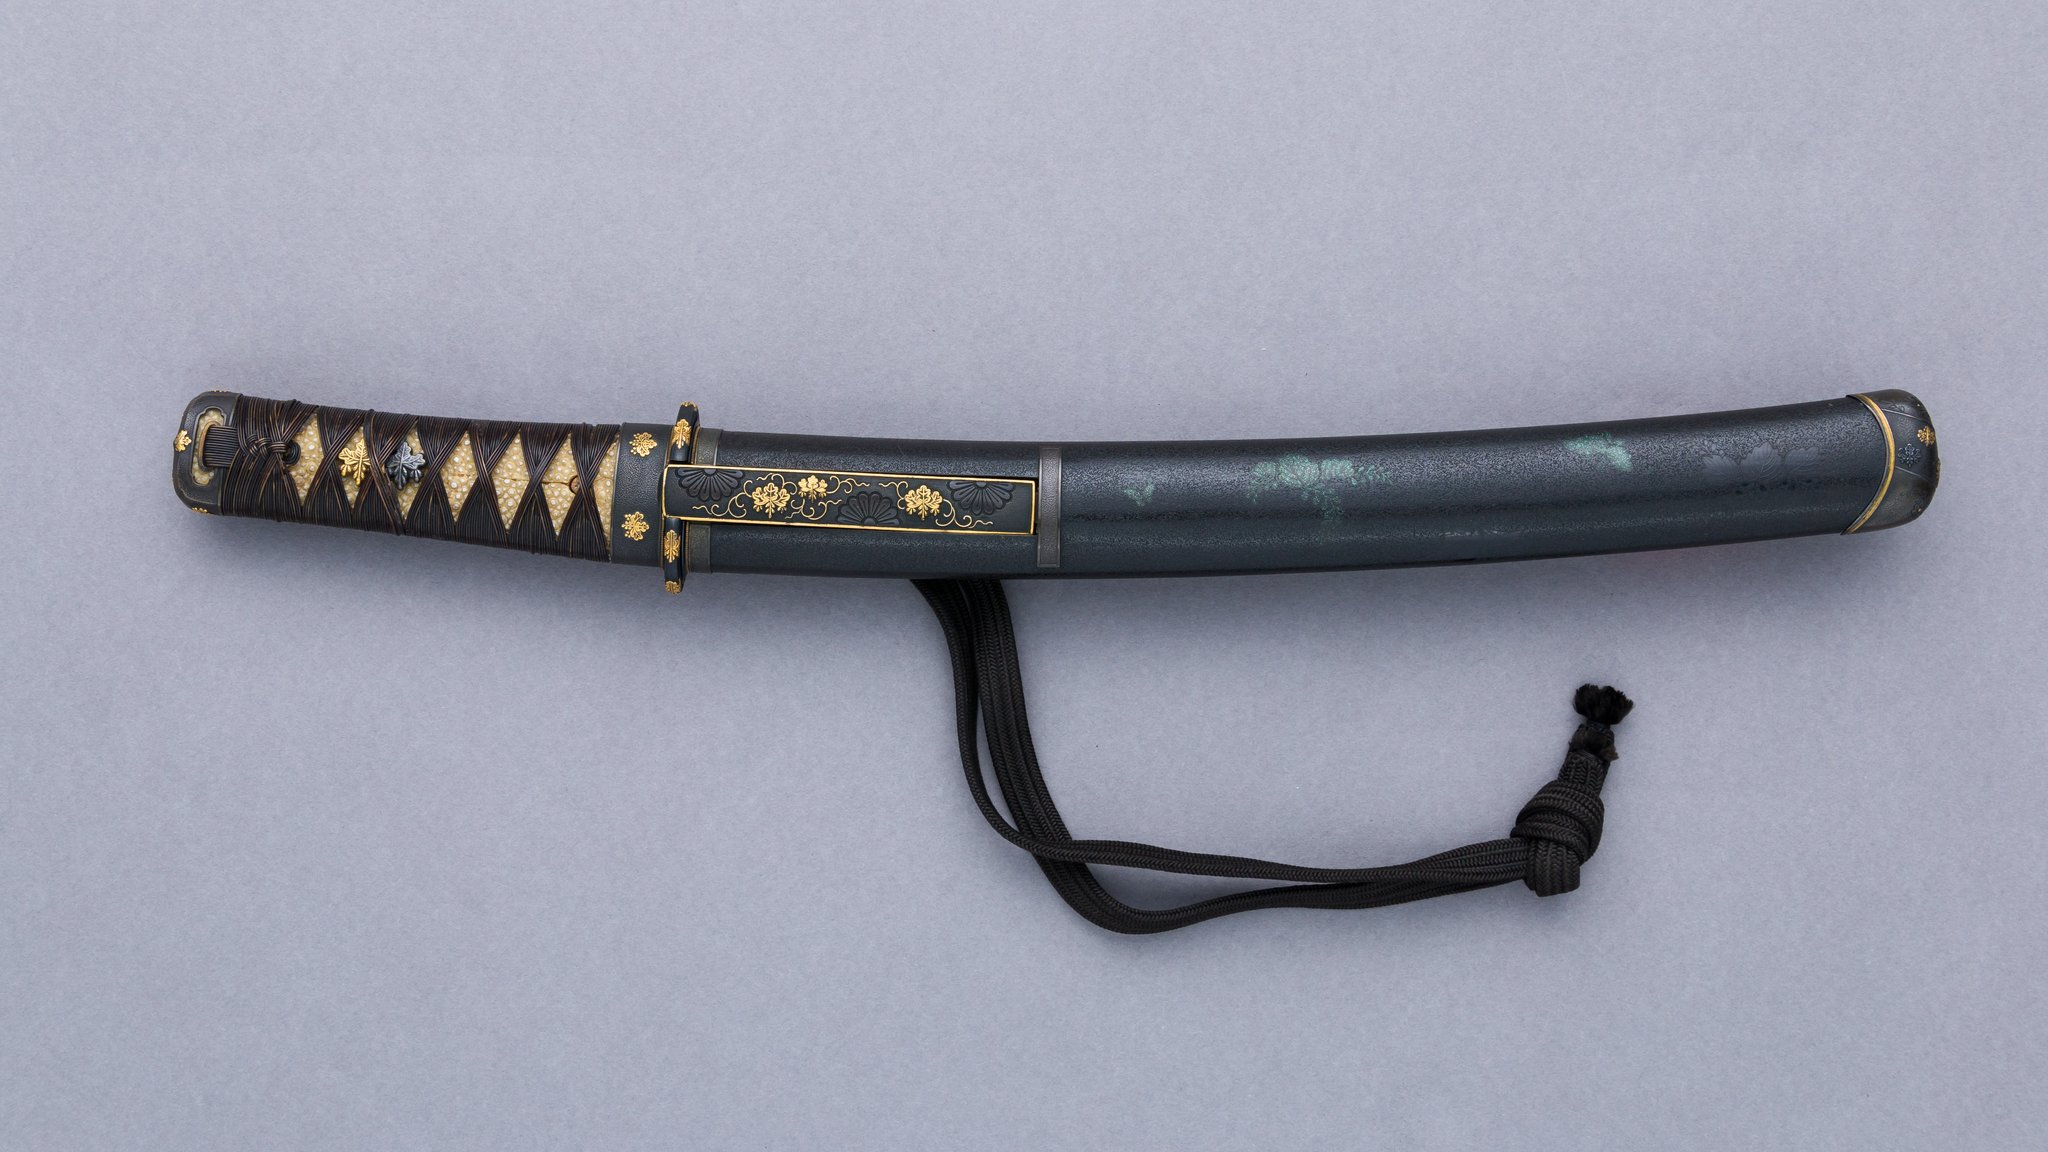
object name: blade and mounting for a dagger tantō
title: Blade for a Dagger (Tantō) with Mounting (Chisagatana)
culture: japanese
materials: bone, gold alloy, silver alloy, lacquer, shell, silk, skin, steel, wood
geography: japan